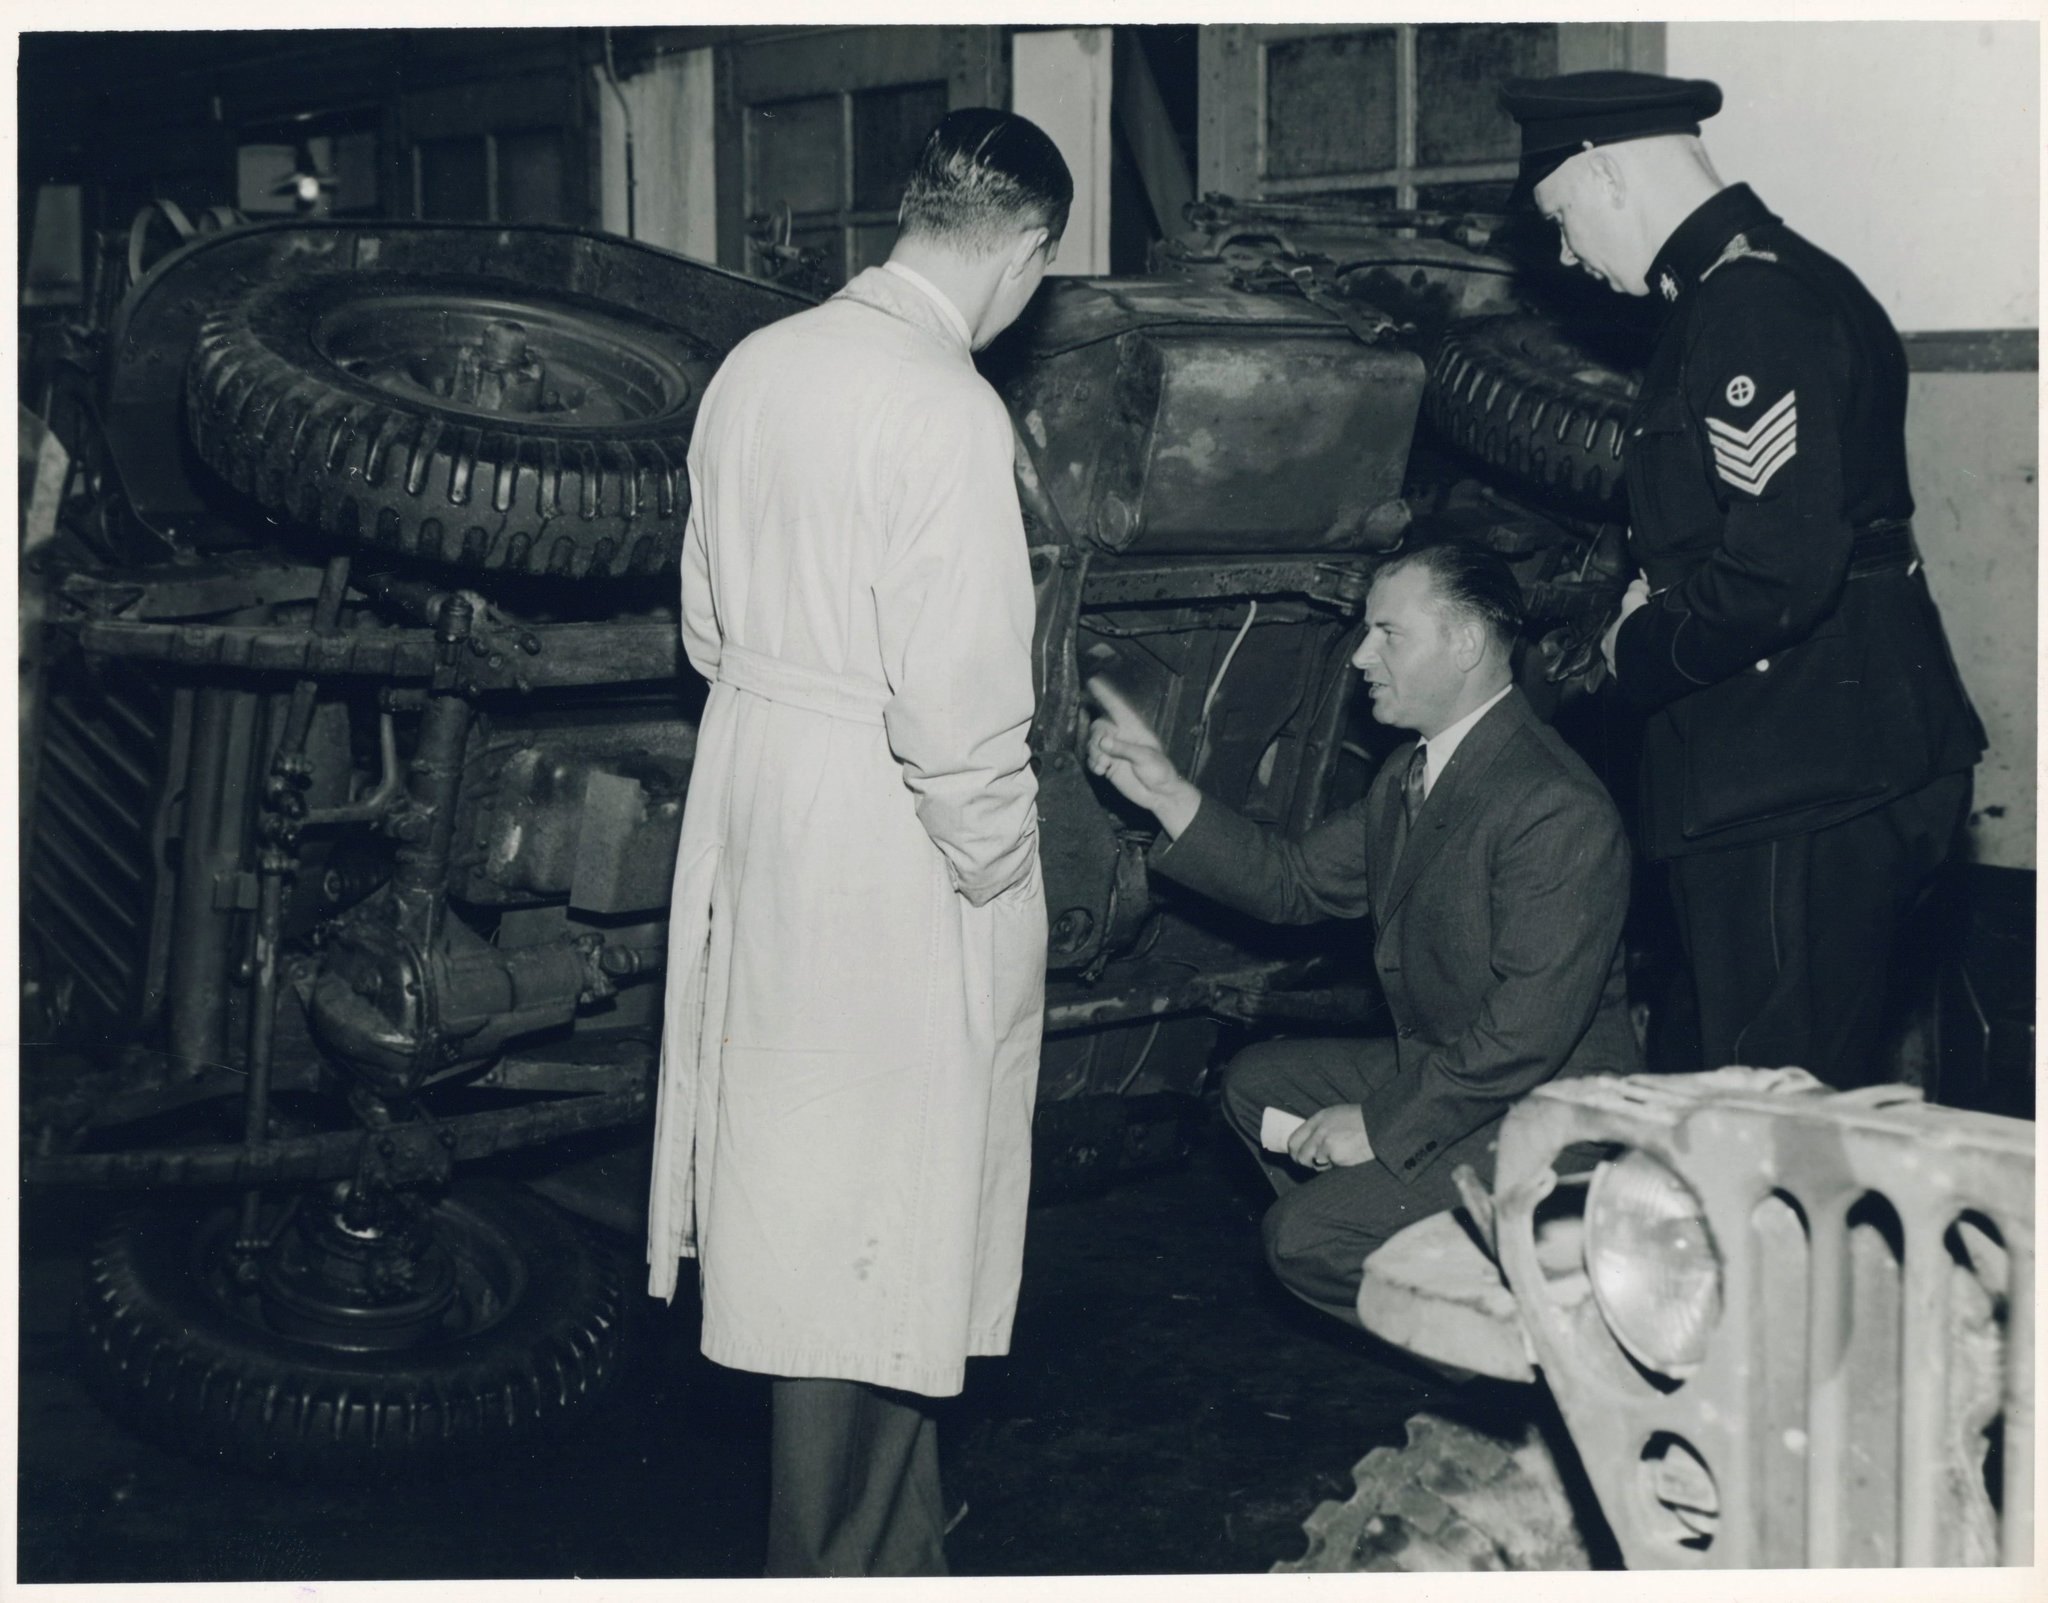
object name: documentary photograph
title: Jeeps uit de USA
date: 1946-1947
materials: photographic support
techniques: photography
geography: netherlands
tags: netherlands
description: Voormalige US Army jeeps, zo'n 500, worden gebruikt door de Nederlandse politie.